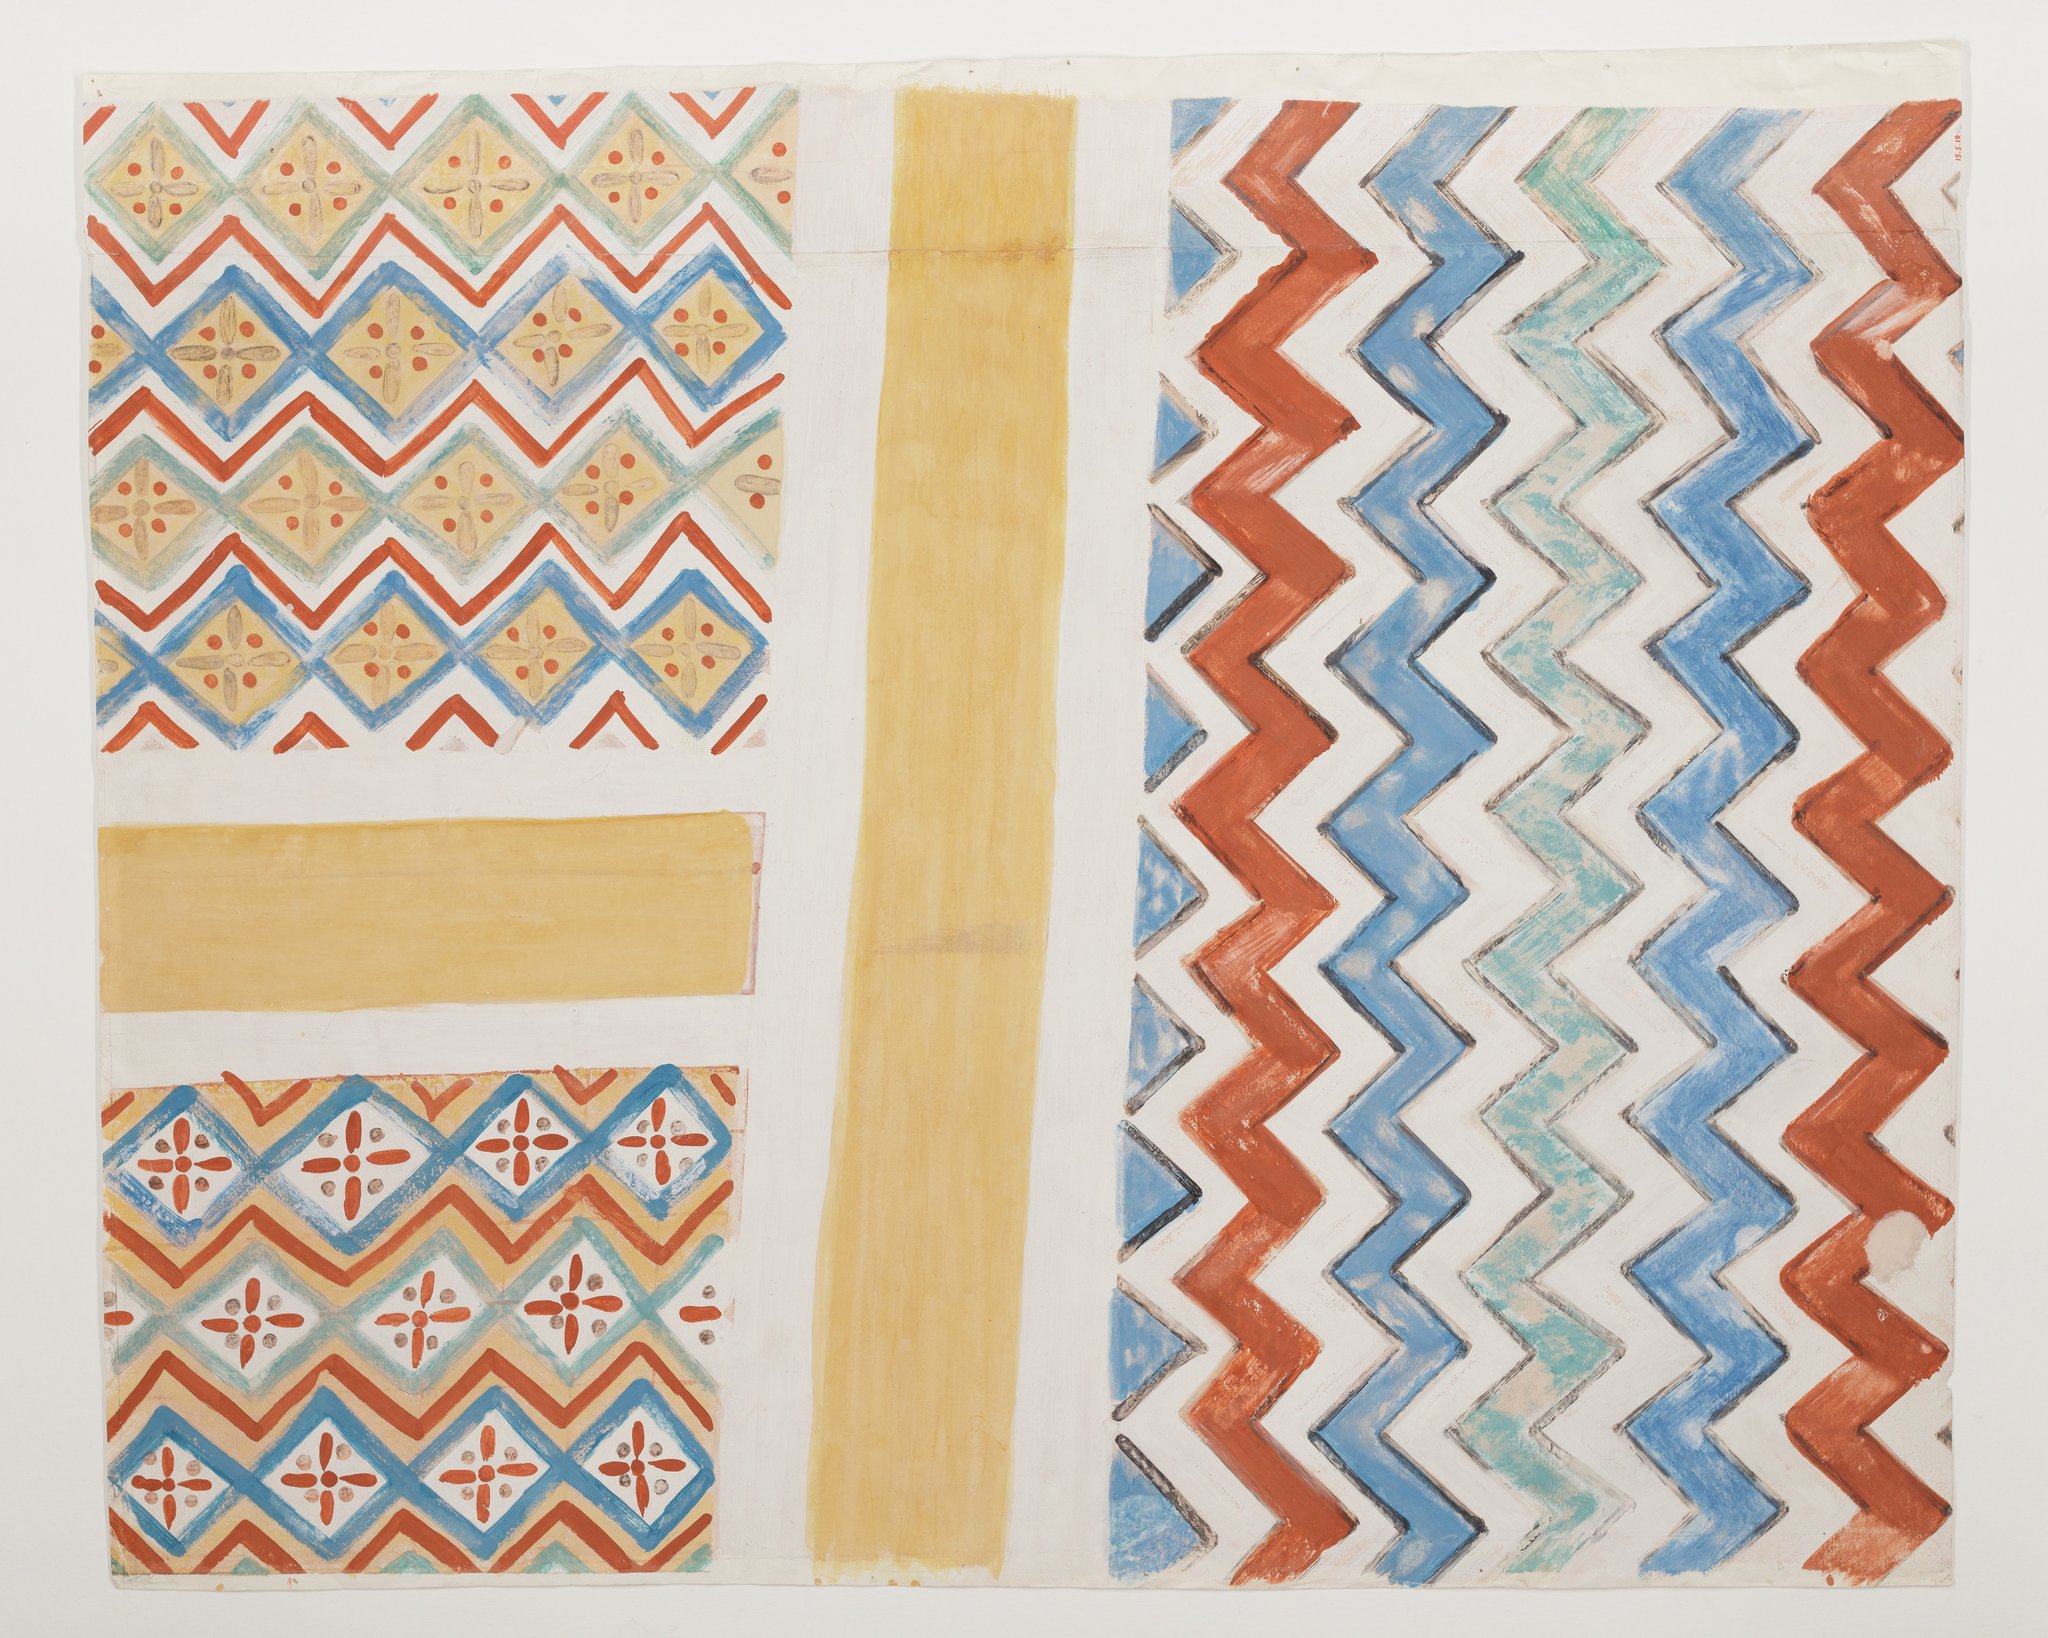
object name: facsimile, nakht tt 52, ceiling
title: Ceiling on the North Side of Nakht's Offering Chapel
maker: norman de garis davies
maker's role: artist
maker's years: 1865-1941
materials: paper, paint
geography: egypt